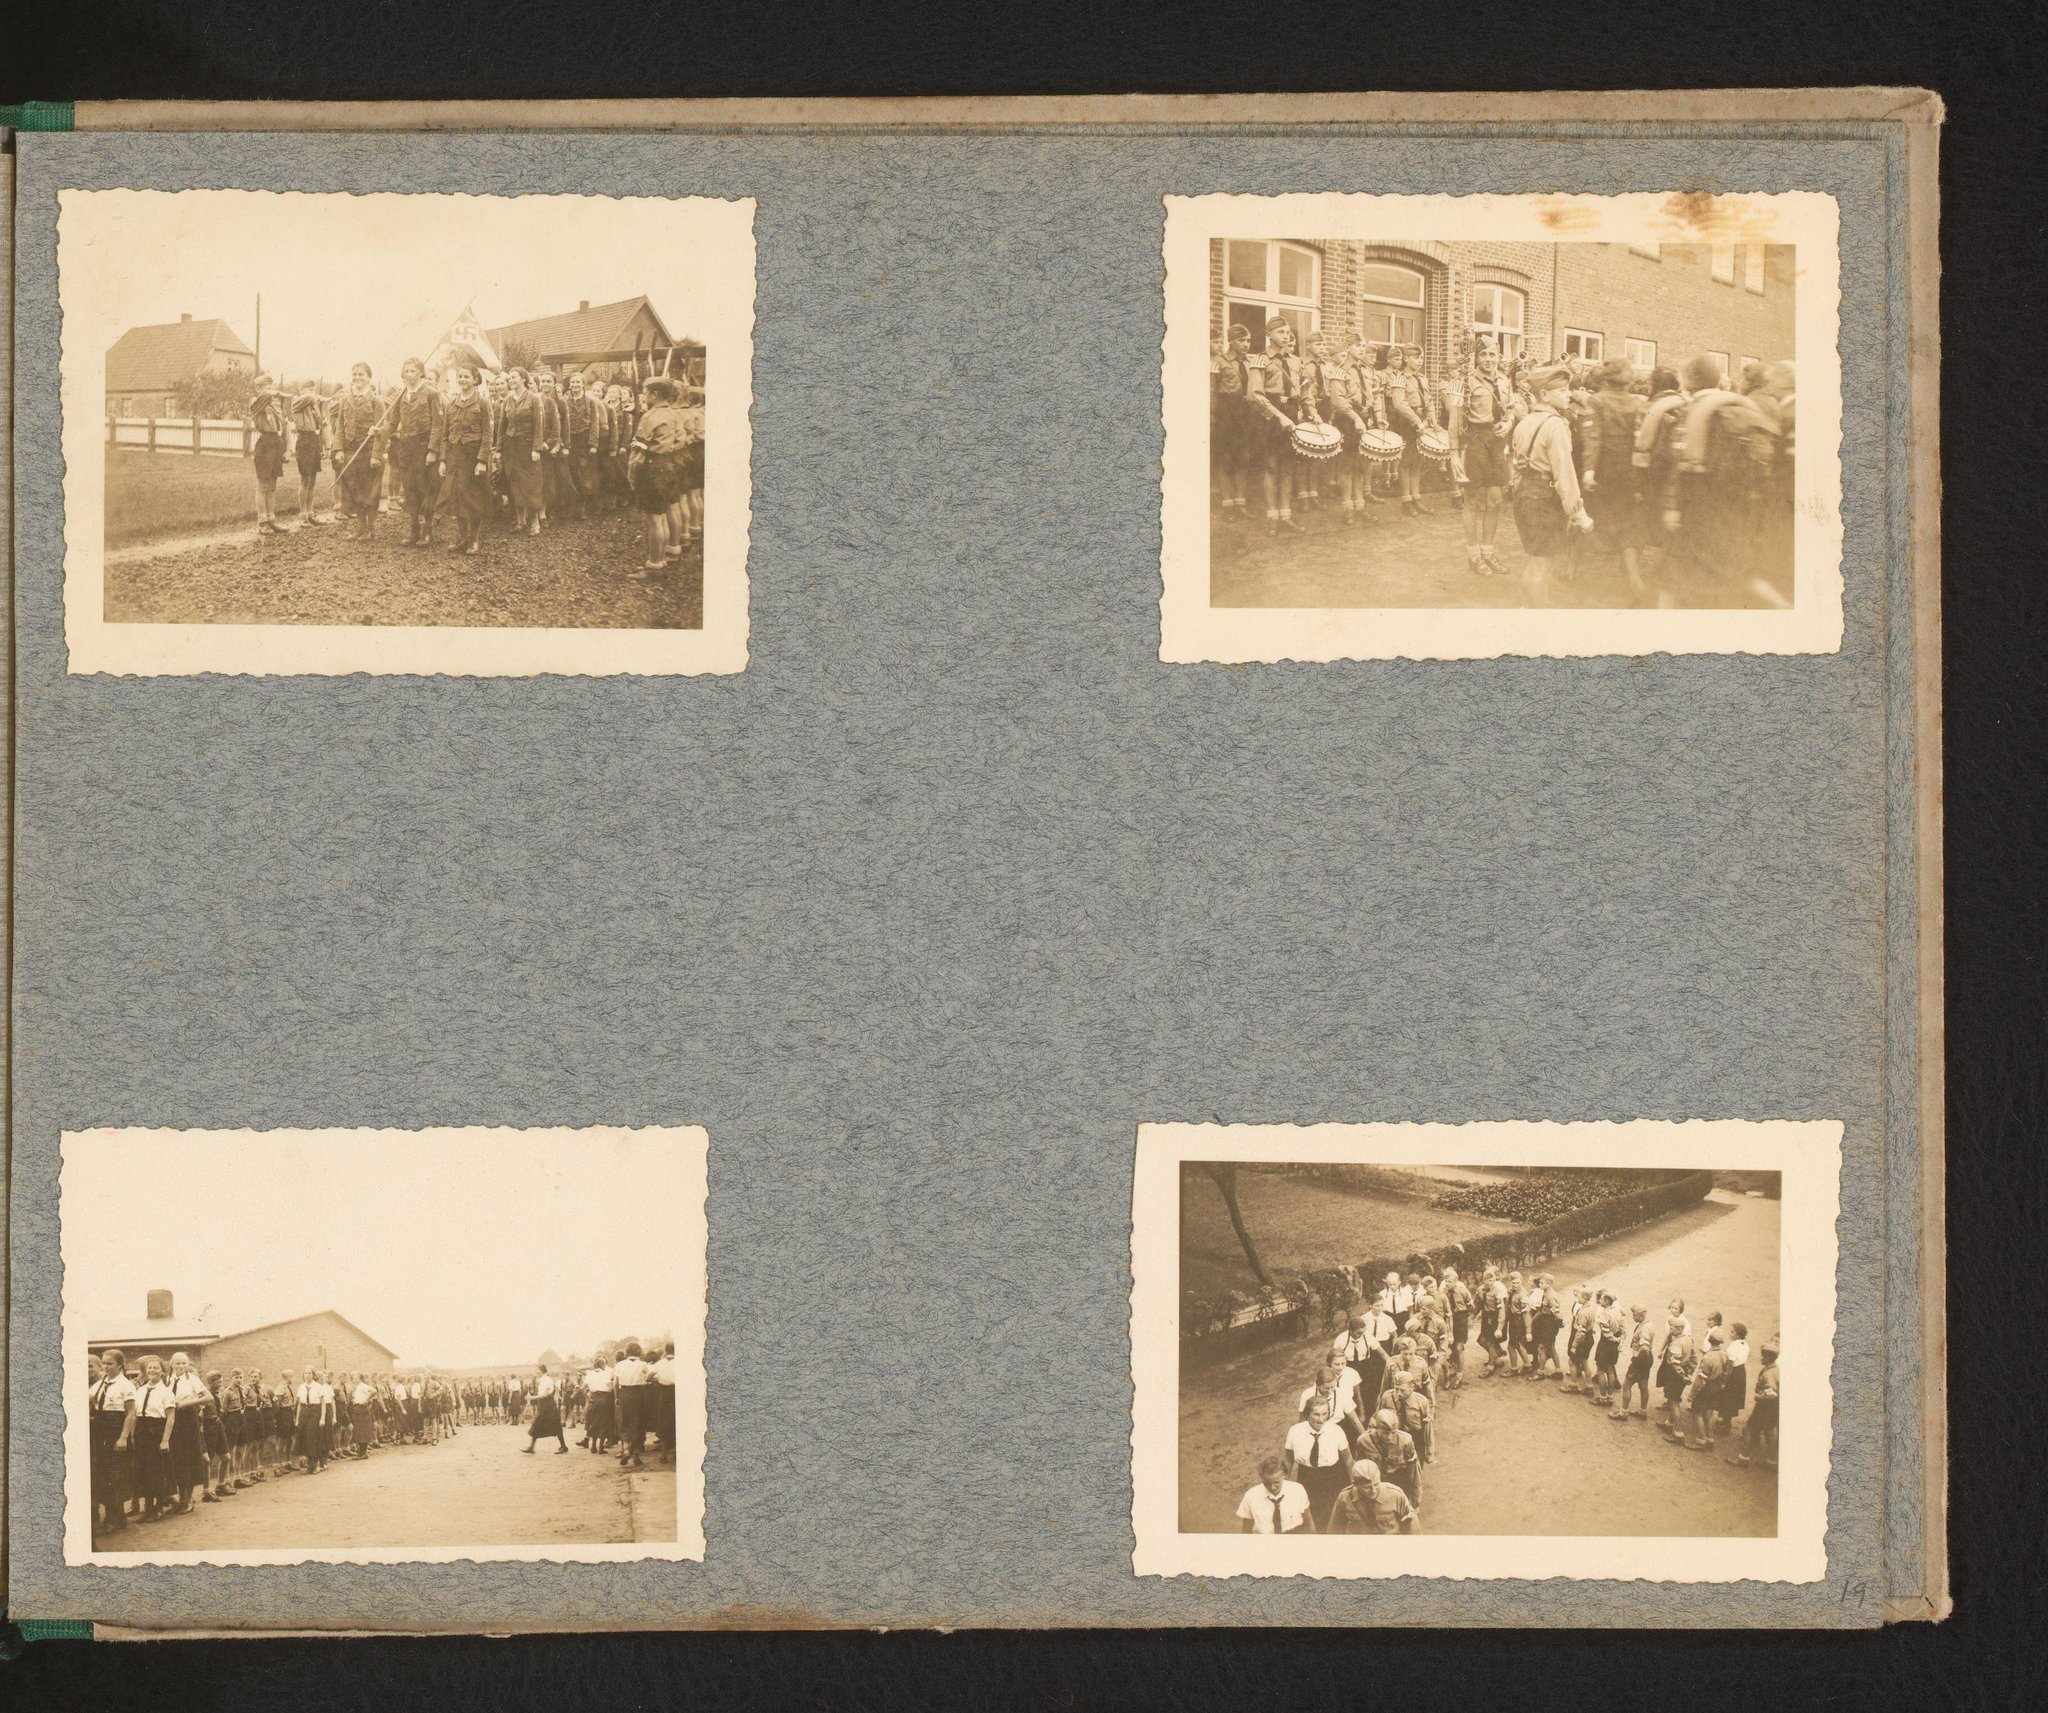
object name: album leaf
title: Hitlerjugend en Bund Deutscher Mädel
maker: Anonymous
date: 1935-1938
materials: cardboard, photographic support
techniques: gelatin silver print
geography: germany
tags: military music, military training, drum (musical instrument) - cc - out of doors, germany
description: Albumblad met vier foto's van de jongens en meisjes van de Hitlerjugend en de Bund Deutscher Mädel tijdens marcheren en militaire exercities. Jongens van de Hitlerjugend van Landjahrlager 1935 in Wolmersdorf. Onderdeel van het Hitlerjugend fotoalbum.